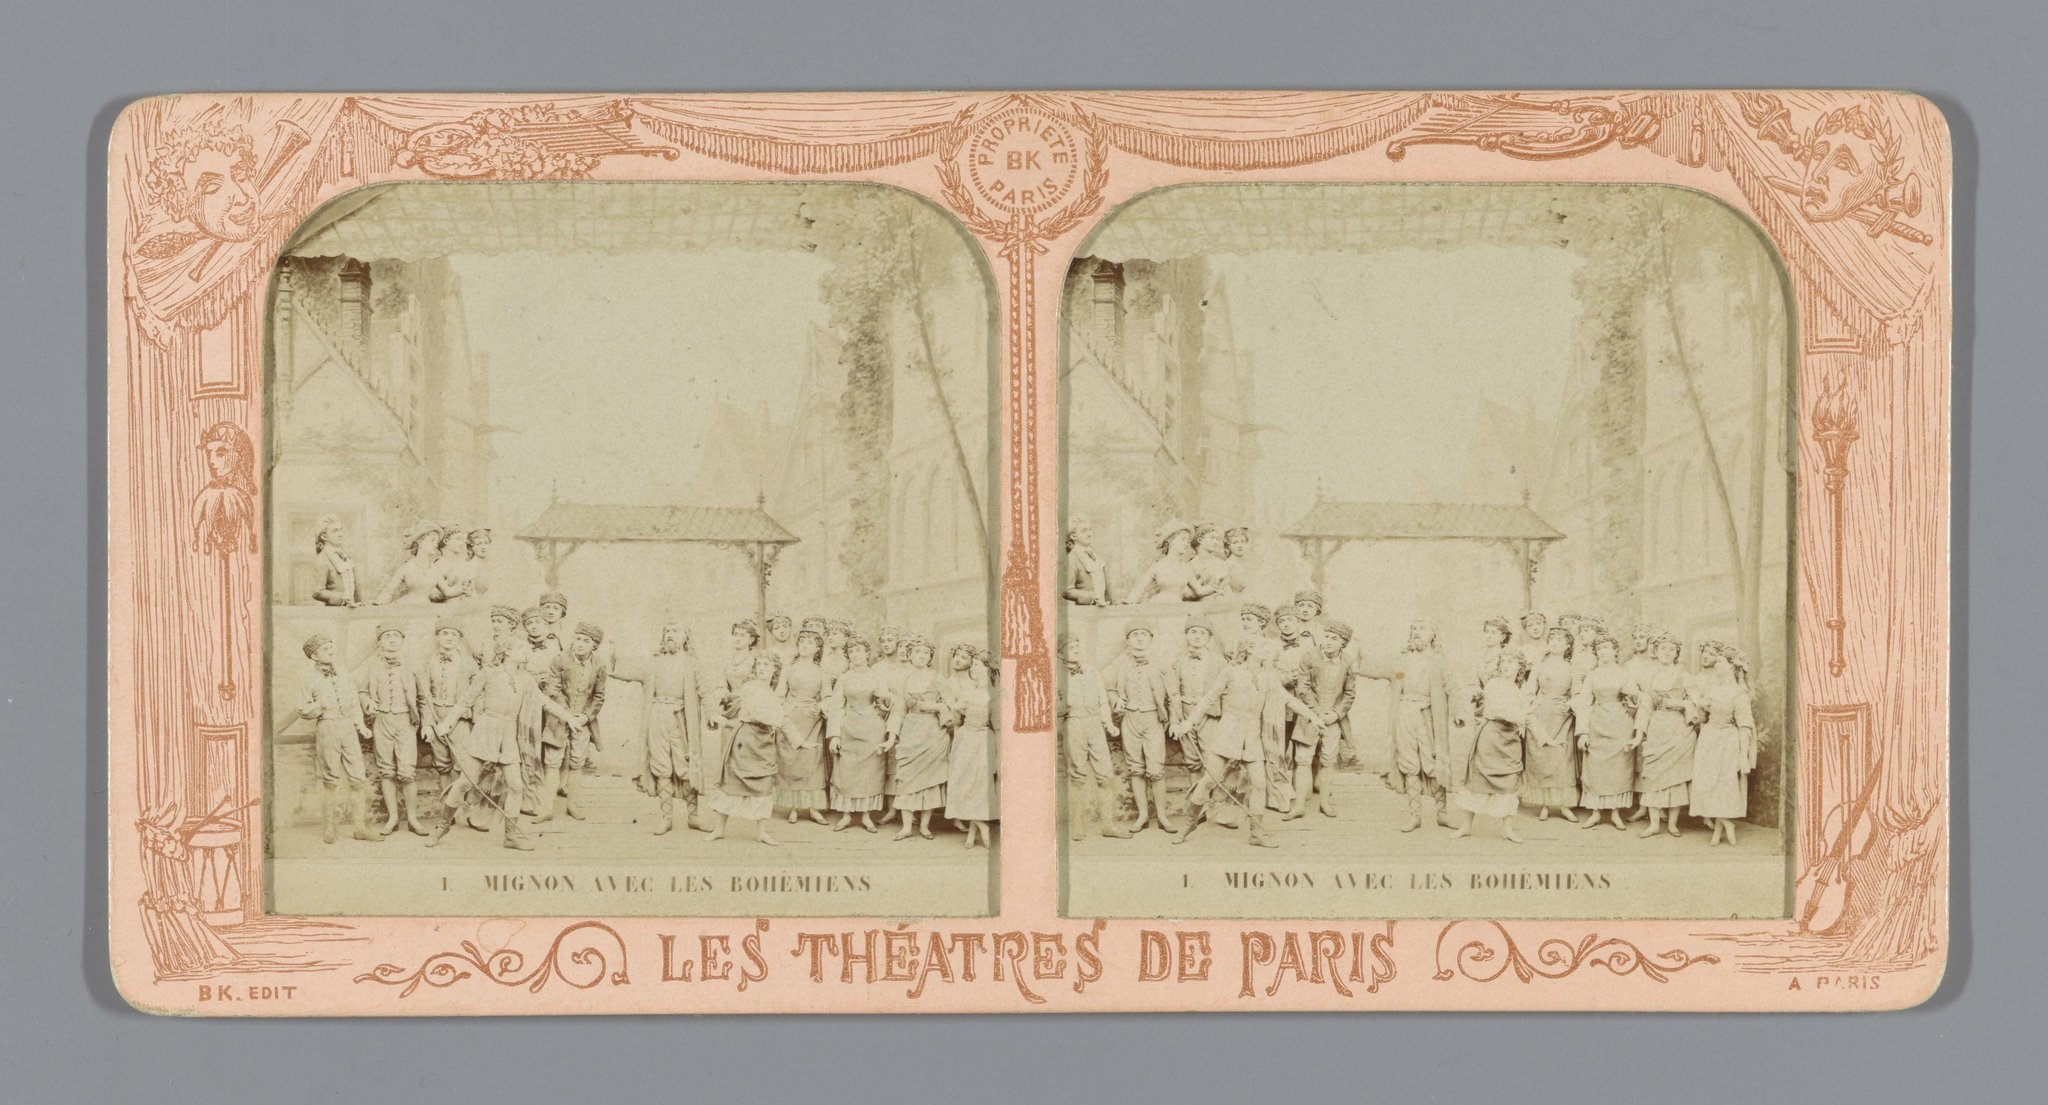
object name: stereograph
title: Stereofoto van het theater in Parijs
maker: Anonymous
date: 1867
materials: cardboard, photographic support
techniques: albumen print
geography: paris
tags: group of actors, troupe; actors on the stage, paris